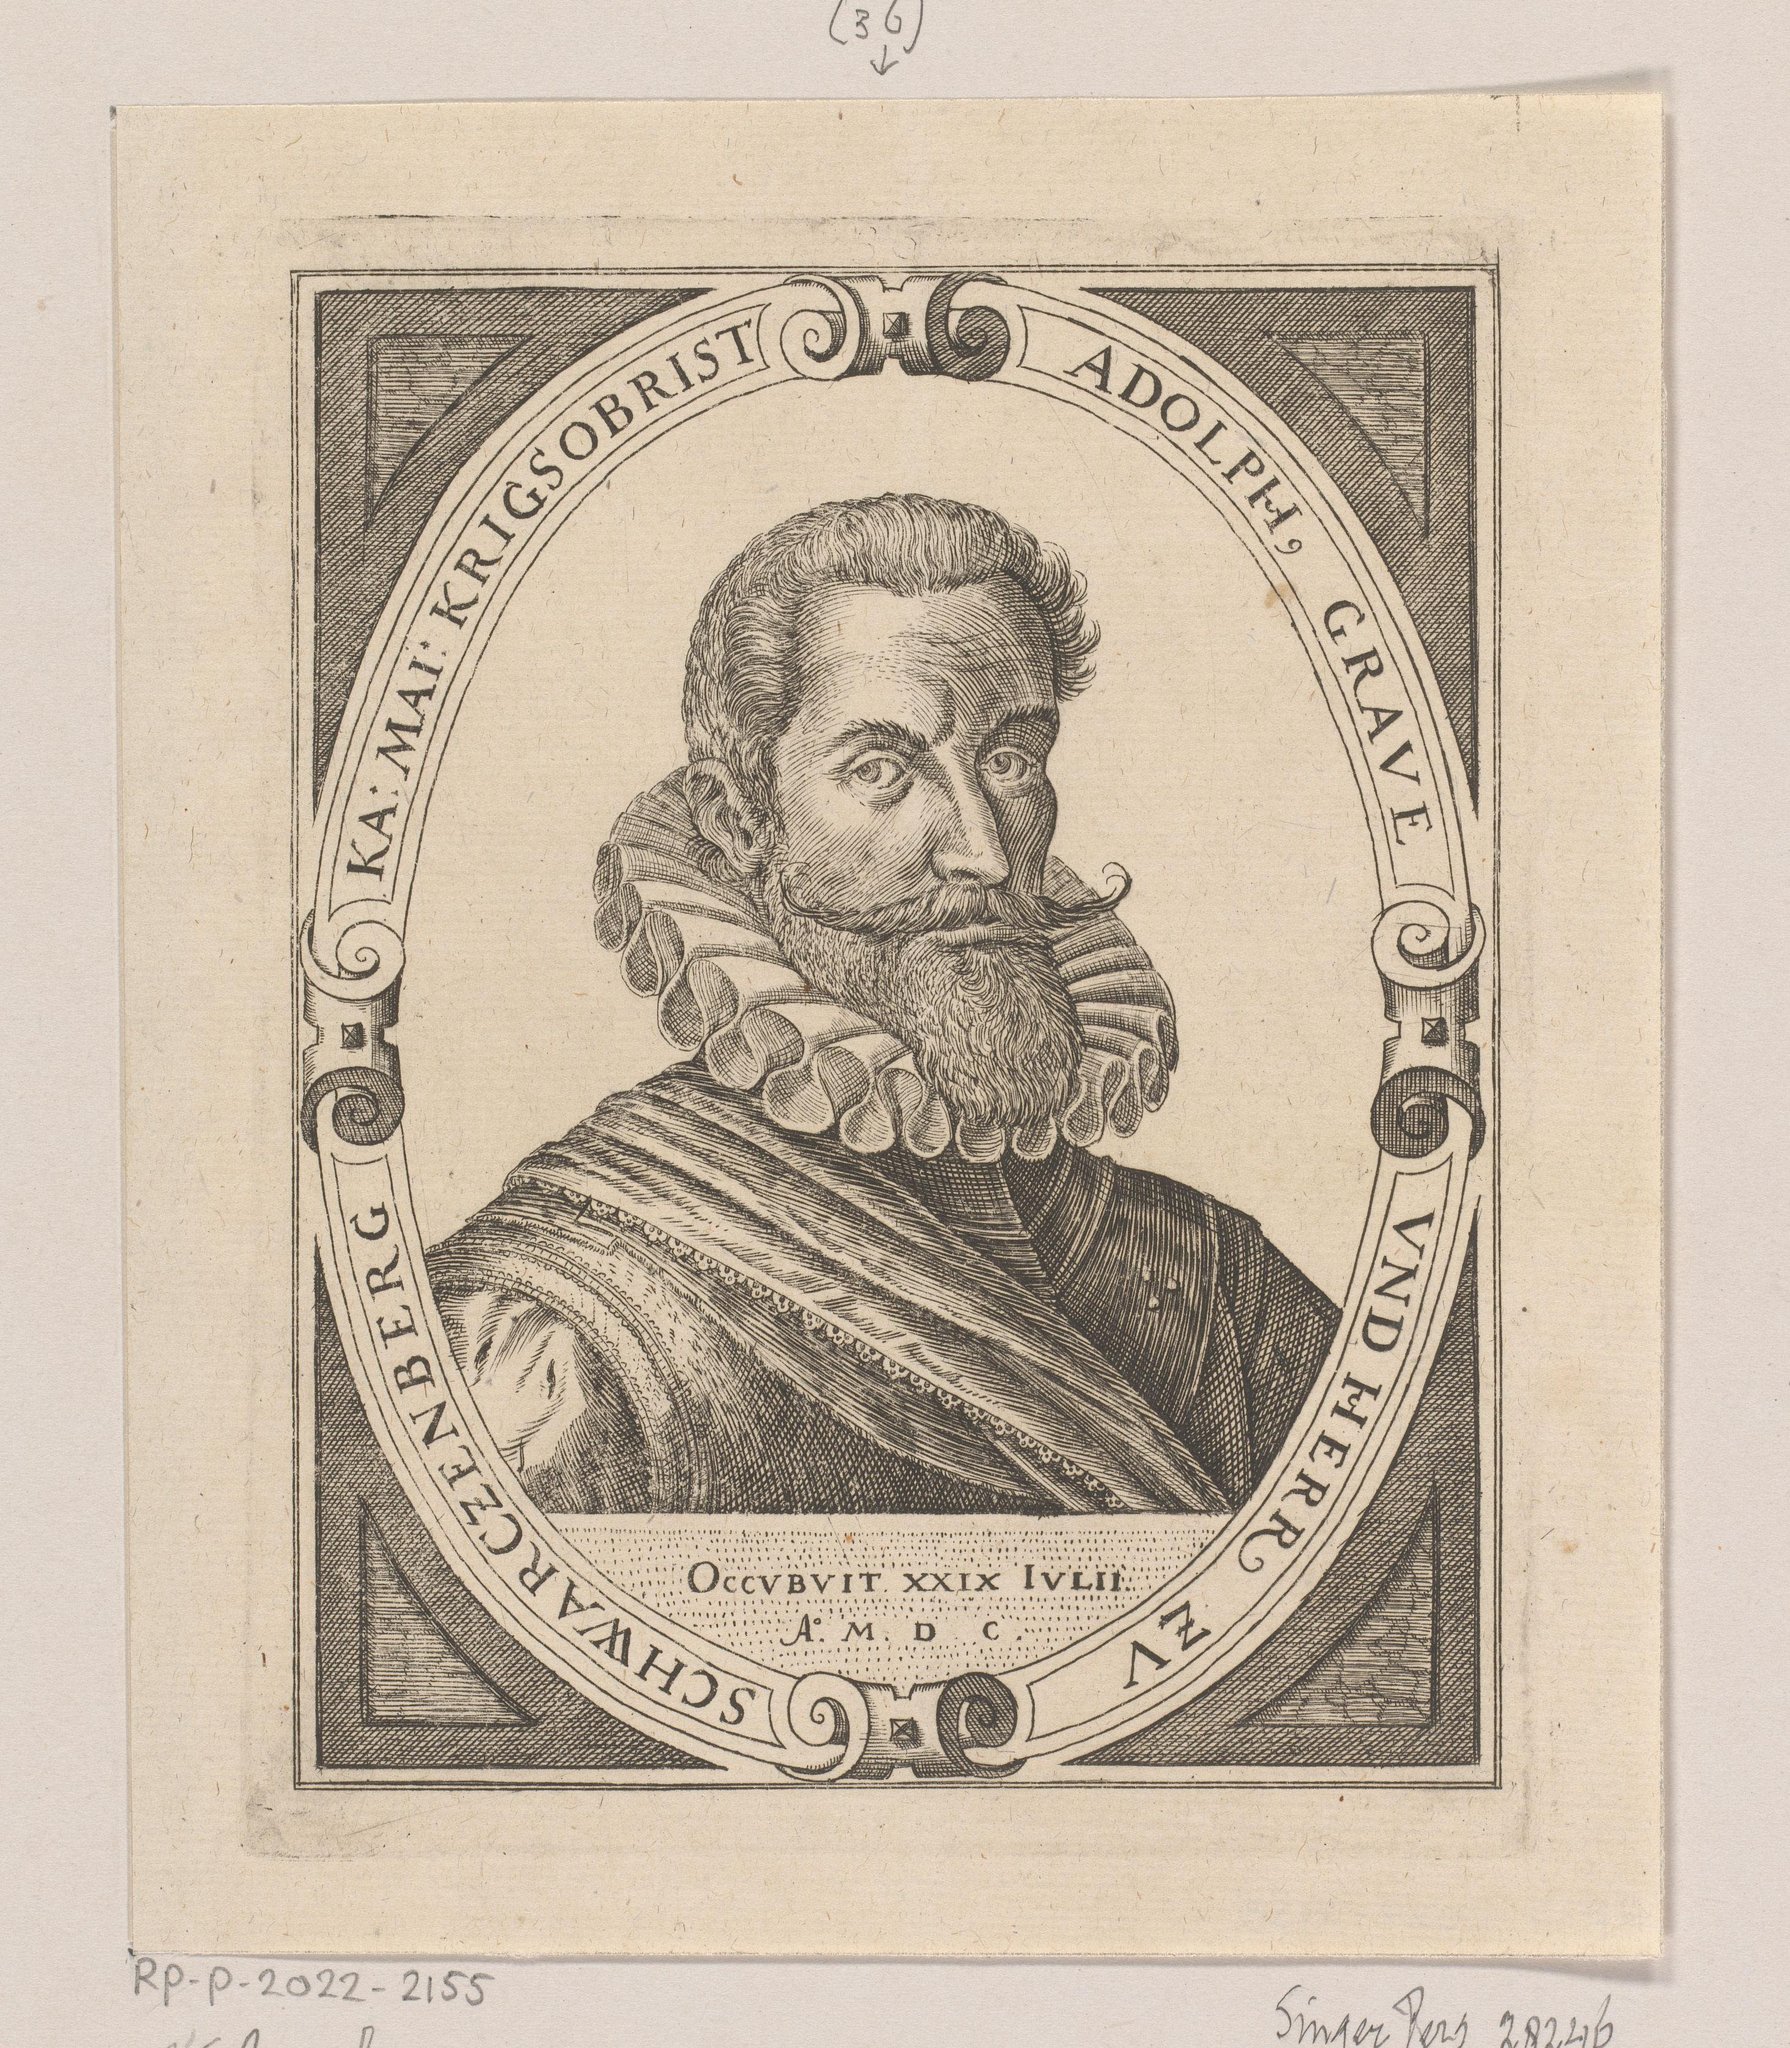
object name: print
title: Portret van Adolf von Schwarzenberg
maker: hans sibmacher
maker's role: print maker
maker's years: -1611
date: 1603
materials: paper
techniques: engraving, etching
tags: adolf von schwarzenberg (graaf), commander-in-chief, general, marshal, historical persons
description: Prent waarschijnlijk uit: Ortel, Hieronymus. Chronologia Oder Historische beschreibung aller Kriegsempörungen (...). Neurenberg: Johann Sibmacher, 1603.